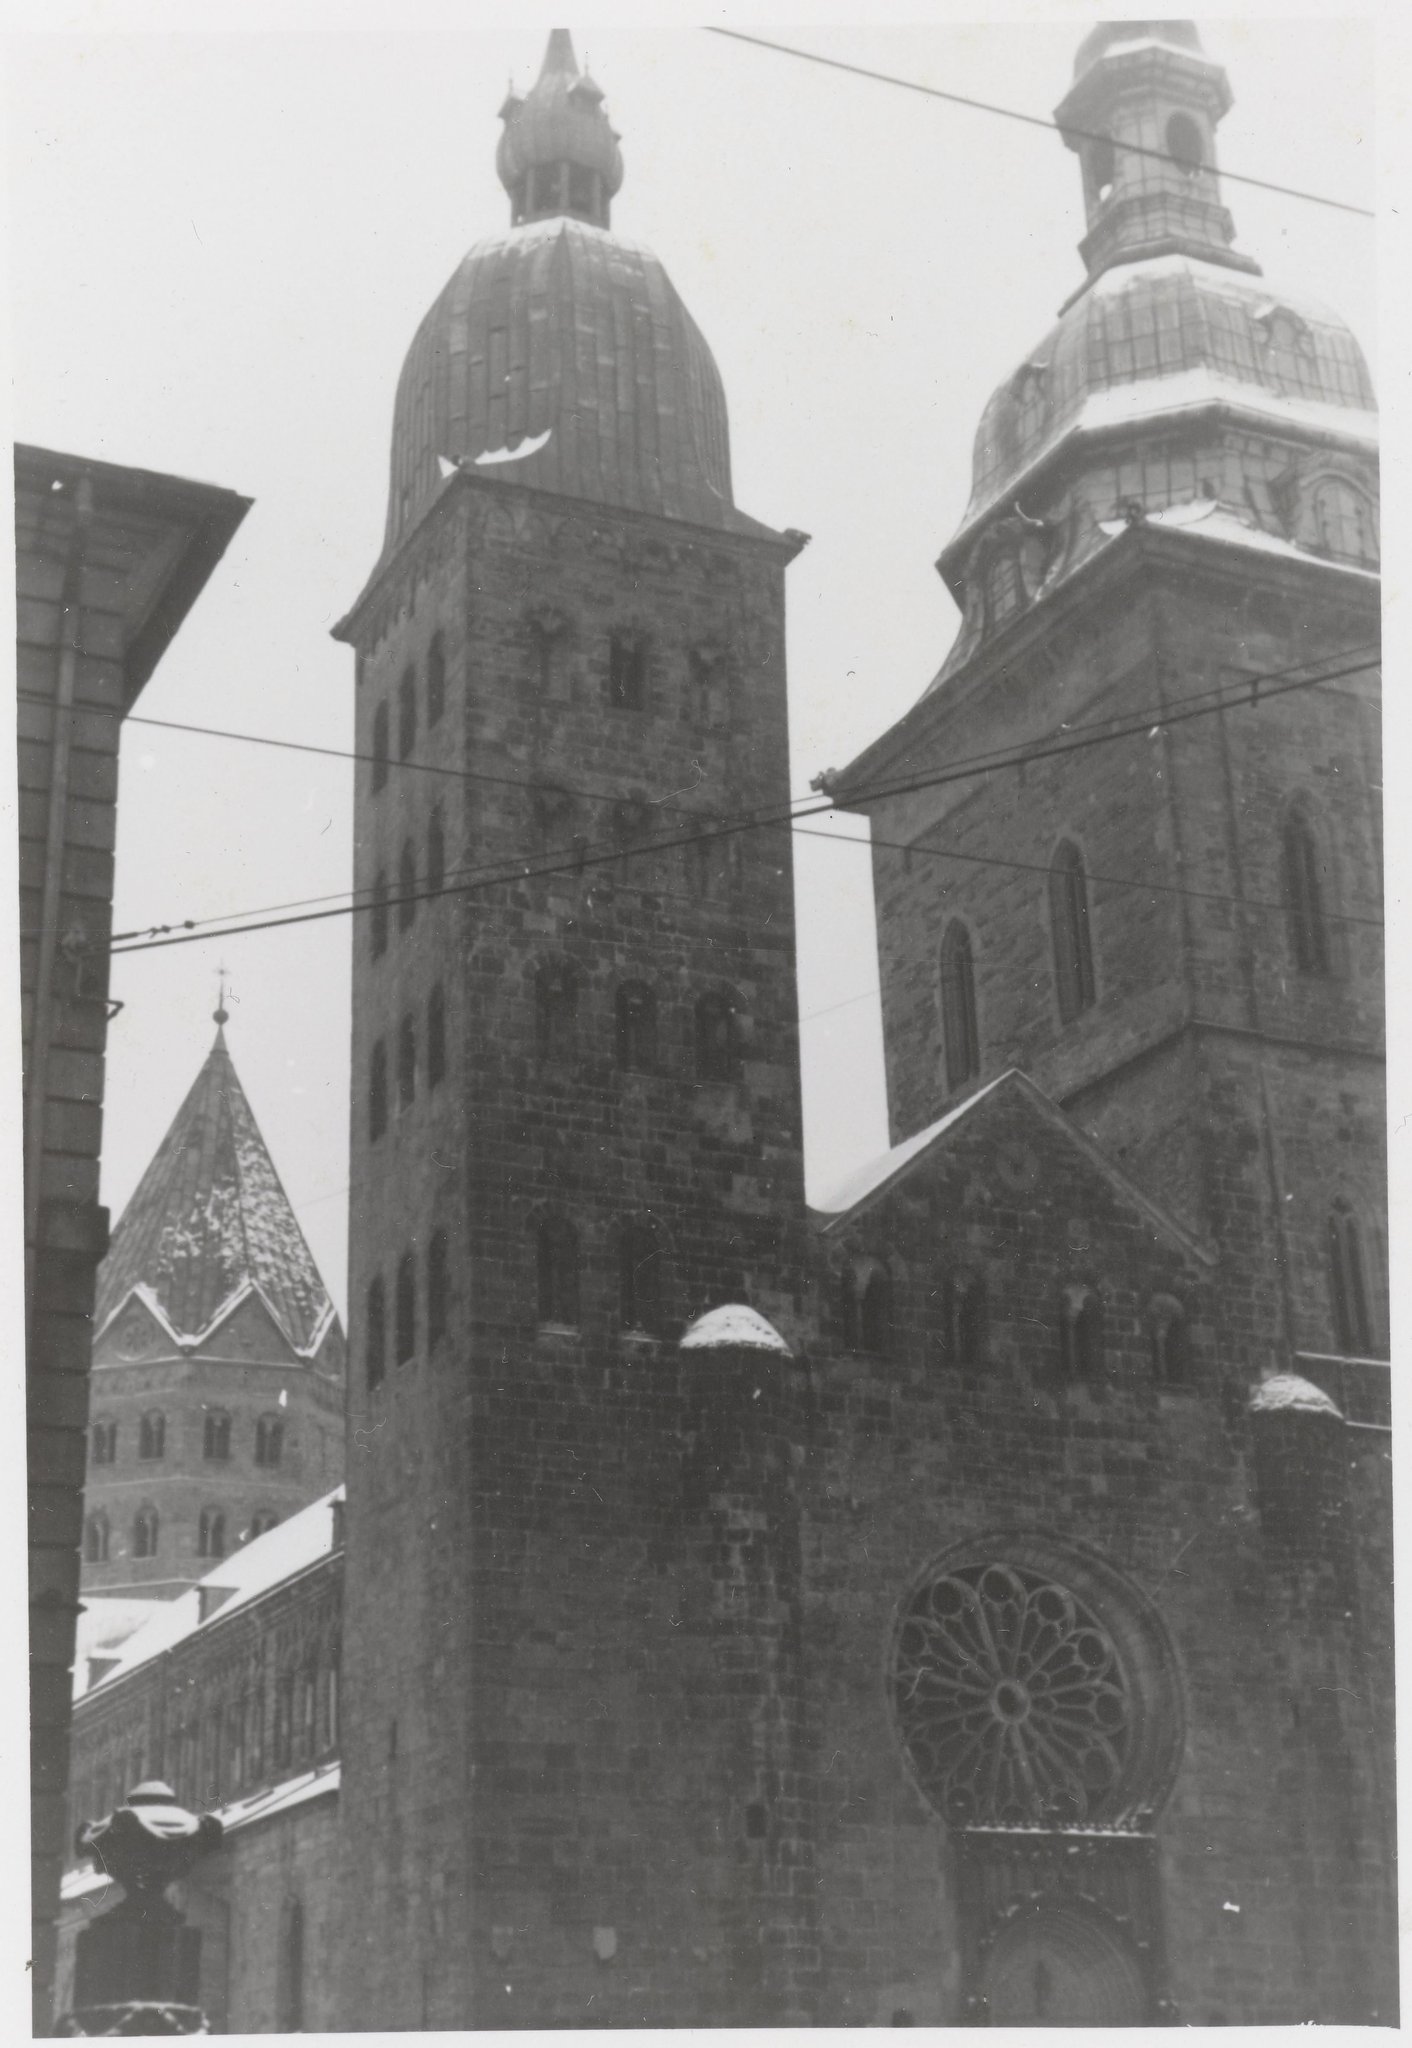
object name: photograph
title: De katholieke kathedraal Sint Pieter in Osnabrück, Nedersaksen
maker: Anonymous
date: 1940-1945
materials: photographic support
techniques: gelatin silver print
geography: germany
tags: netherlands, germany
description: De katholieke kathedraal Sint Pieter in Osnabrück, Nedersaksen. Foto behorend bij album 'Kriegserinnerungen'.